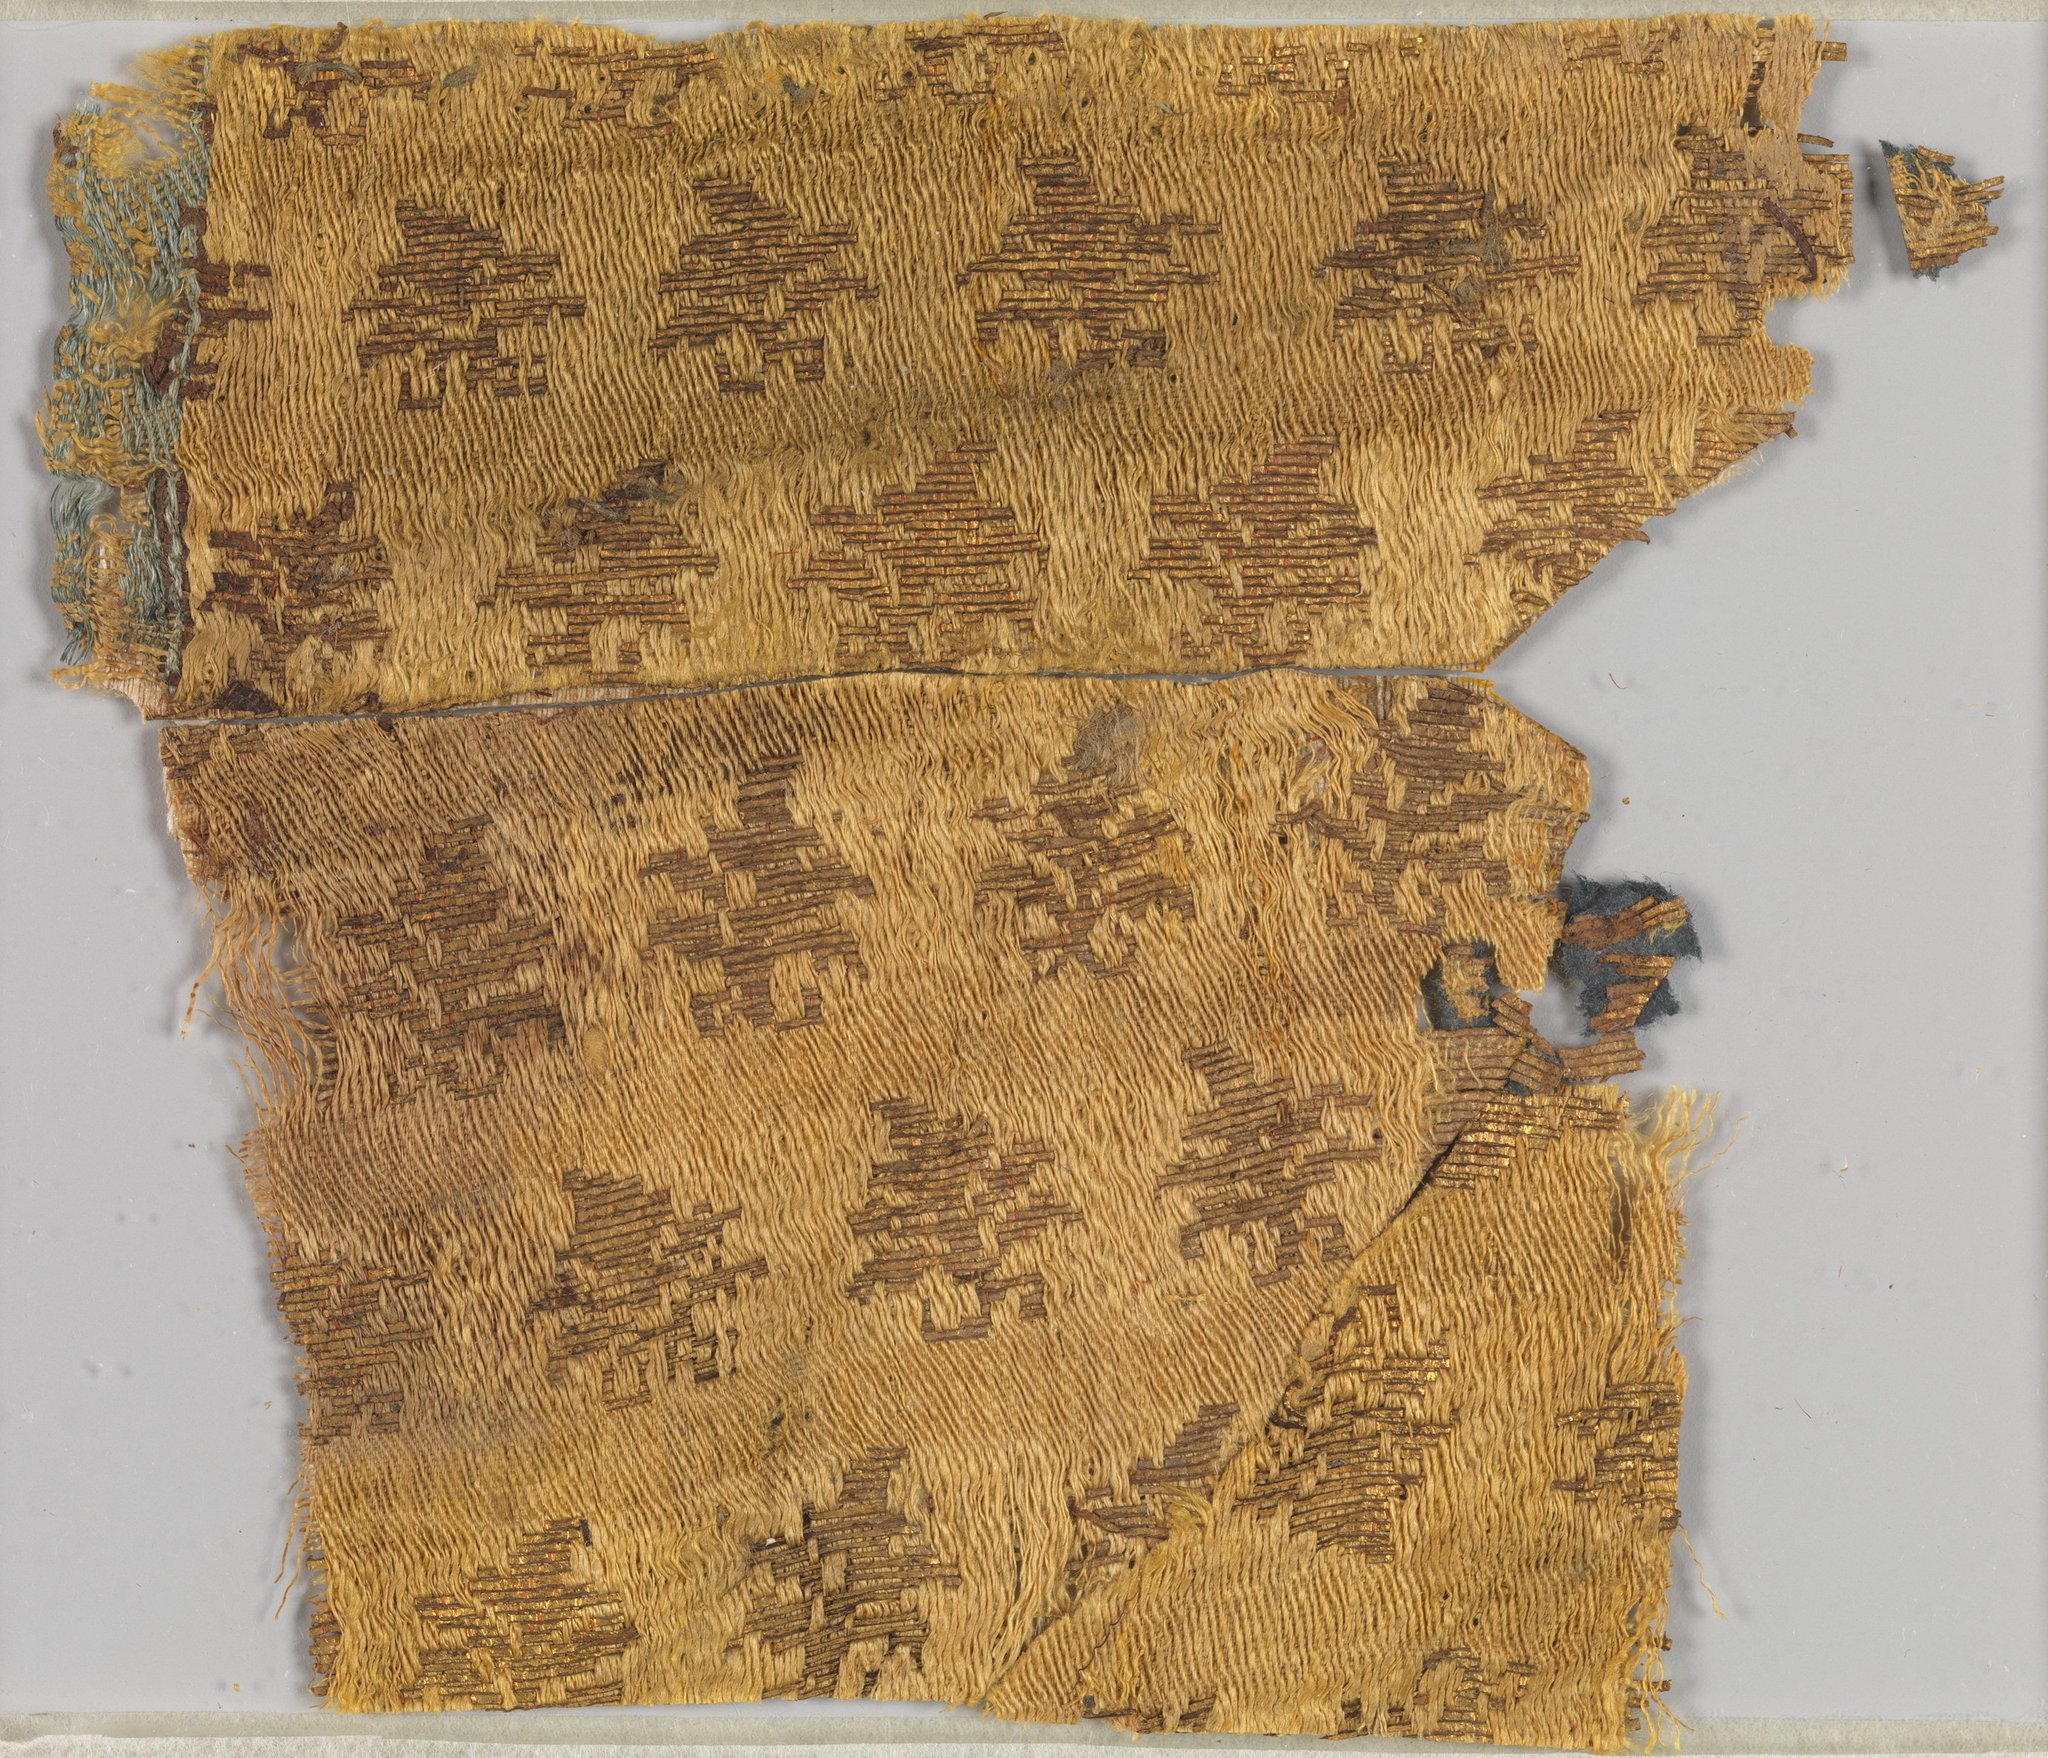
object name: piece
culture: chinese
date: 1301-1400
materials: metal thread, silk